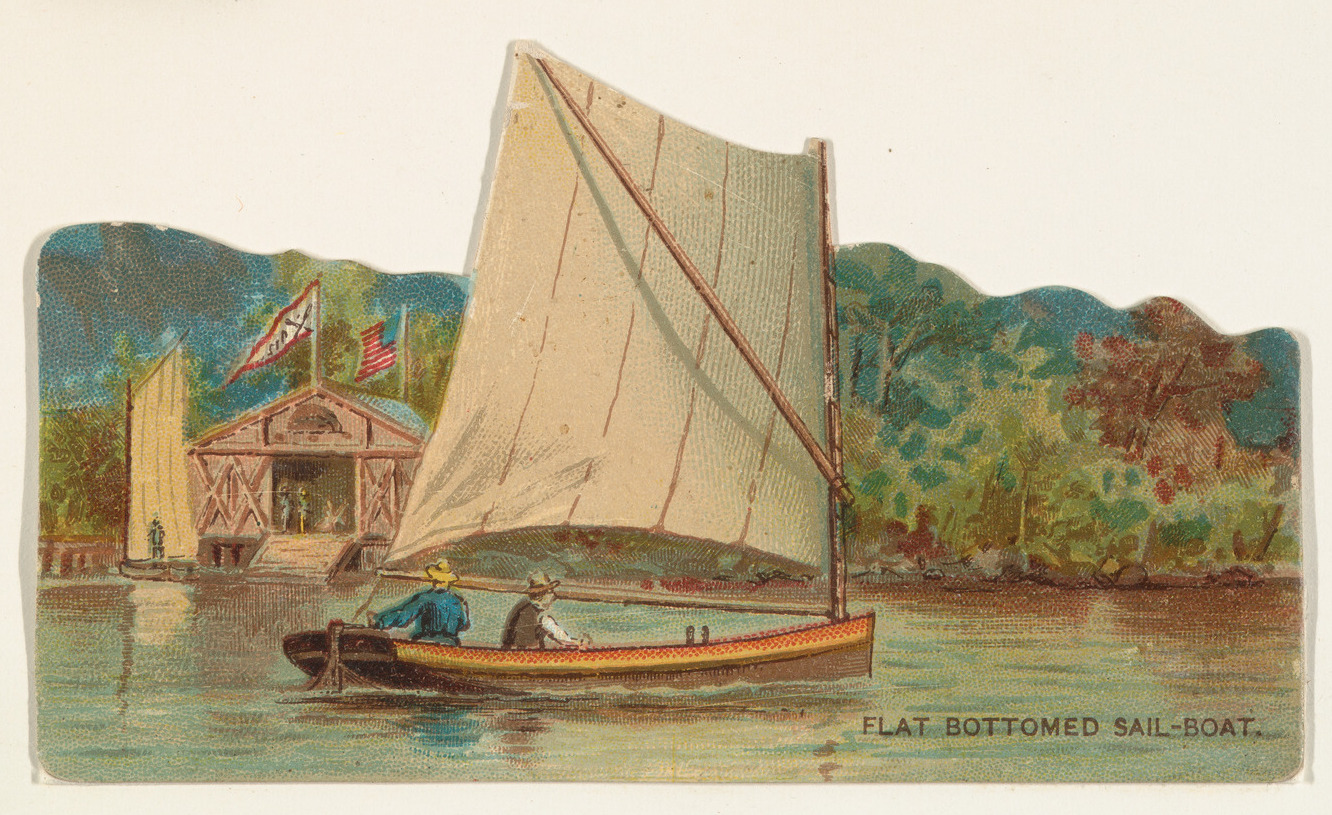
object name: print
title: Flat Bottomed Sailboat, from the Types of Vessels series (N139) issued by Duke Sons & Co. to promote Honest Long Cut Tobacco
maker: w. duke, sons & co.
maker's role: publisher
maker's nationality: american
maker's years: 1870-1920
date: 1889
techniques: color lithograph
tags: boats